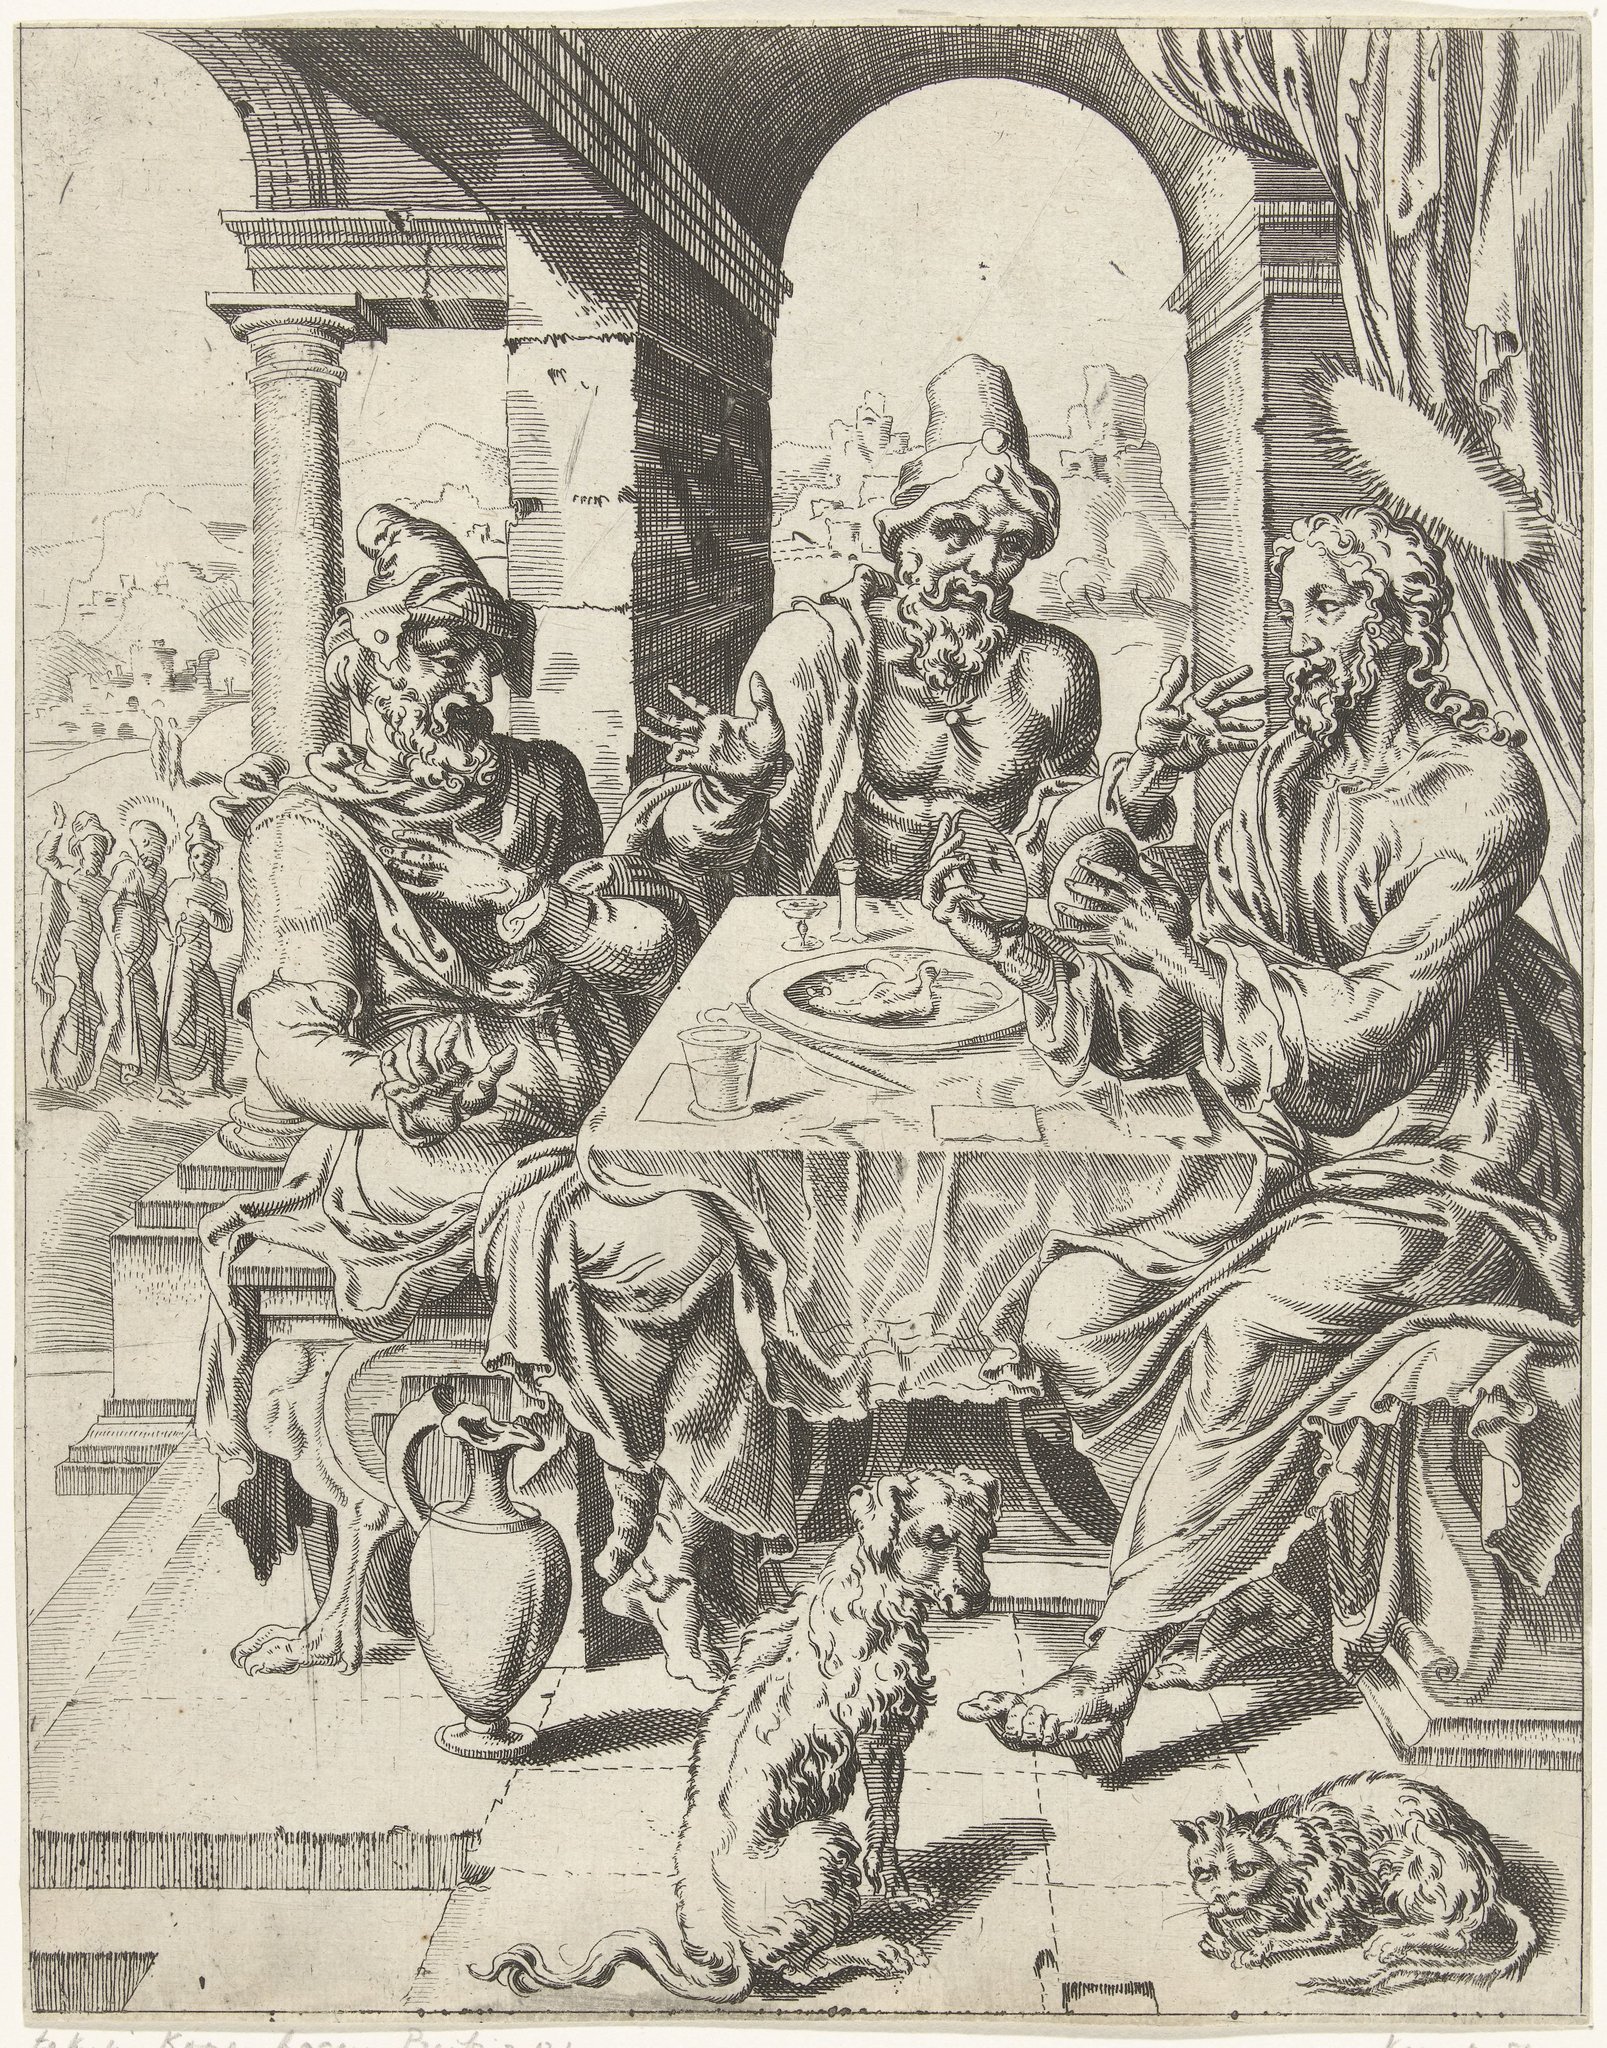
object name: print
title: Maaltijd in Emmaüs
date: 1548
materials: paper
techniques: etching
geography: haarlem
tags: the supper at emmaus: christ is recognized while blessing or breaking the bread, cleopas and peter meet christ (sometimes they are dressed as pilgrims)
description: Christus en twee apostelen zitten rond een tafel. Christus breekt het brood en maakt zo zijn identiteit kenbaar. Op de achtergrond de twee apostelen en Christus op reis naar Emmaüs. De prent is deel van een dertigdelige serie met prenten over de zondeval en Christus' passie.